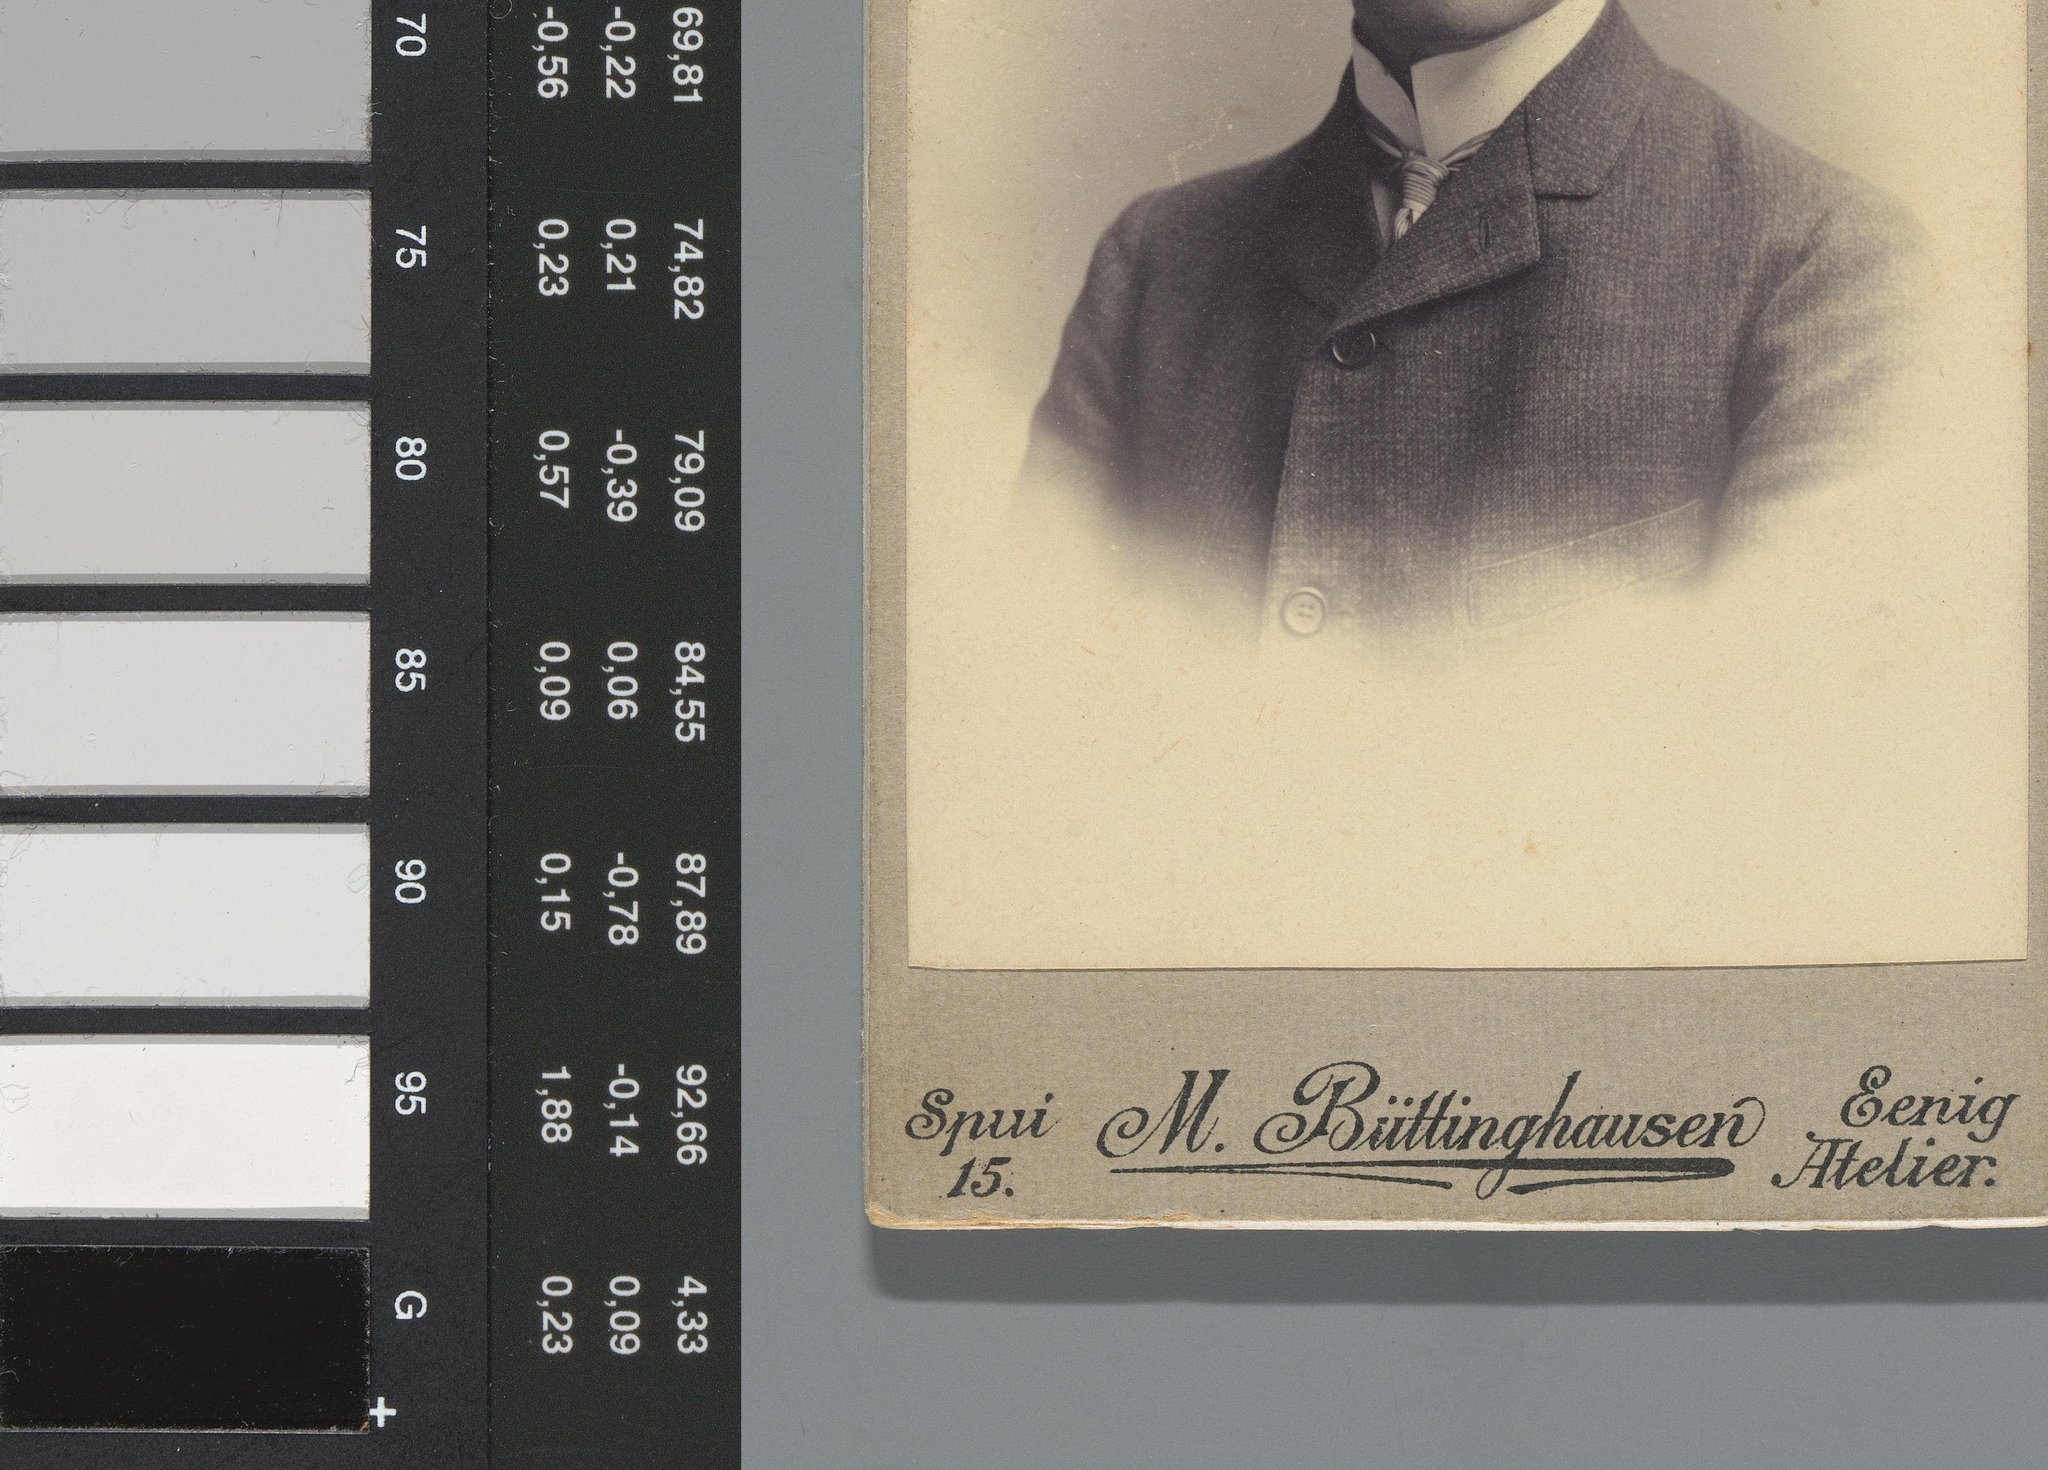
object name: carte de visite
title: Portret van Hendrik Herman van den Berg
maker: max büttinghausen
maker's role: fotograaf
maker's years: 1847-1906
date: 1898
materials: cardboard, photographic support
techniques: albumen print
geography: amsterdam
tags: batavia, amsterdam, hendrik herman van den berg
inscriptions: inscription: ‘± 1898’, inscription: ‘Spui / 15 / M. Büttinghausen / Eenig / Atelier.’